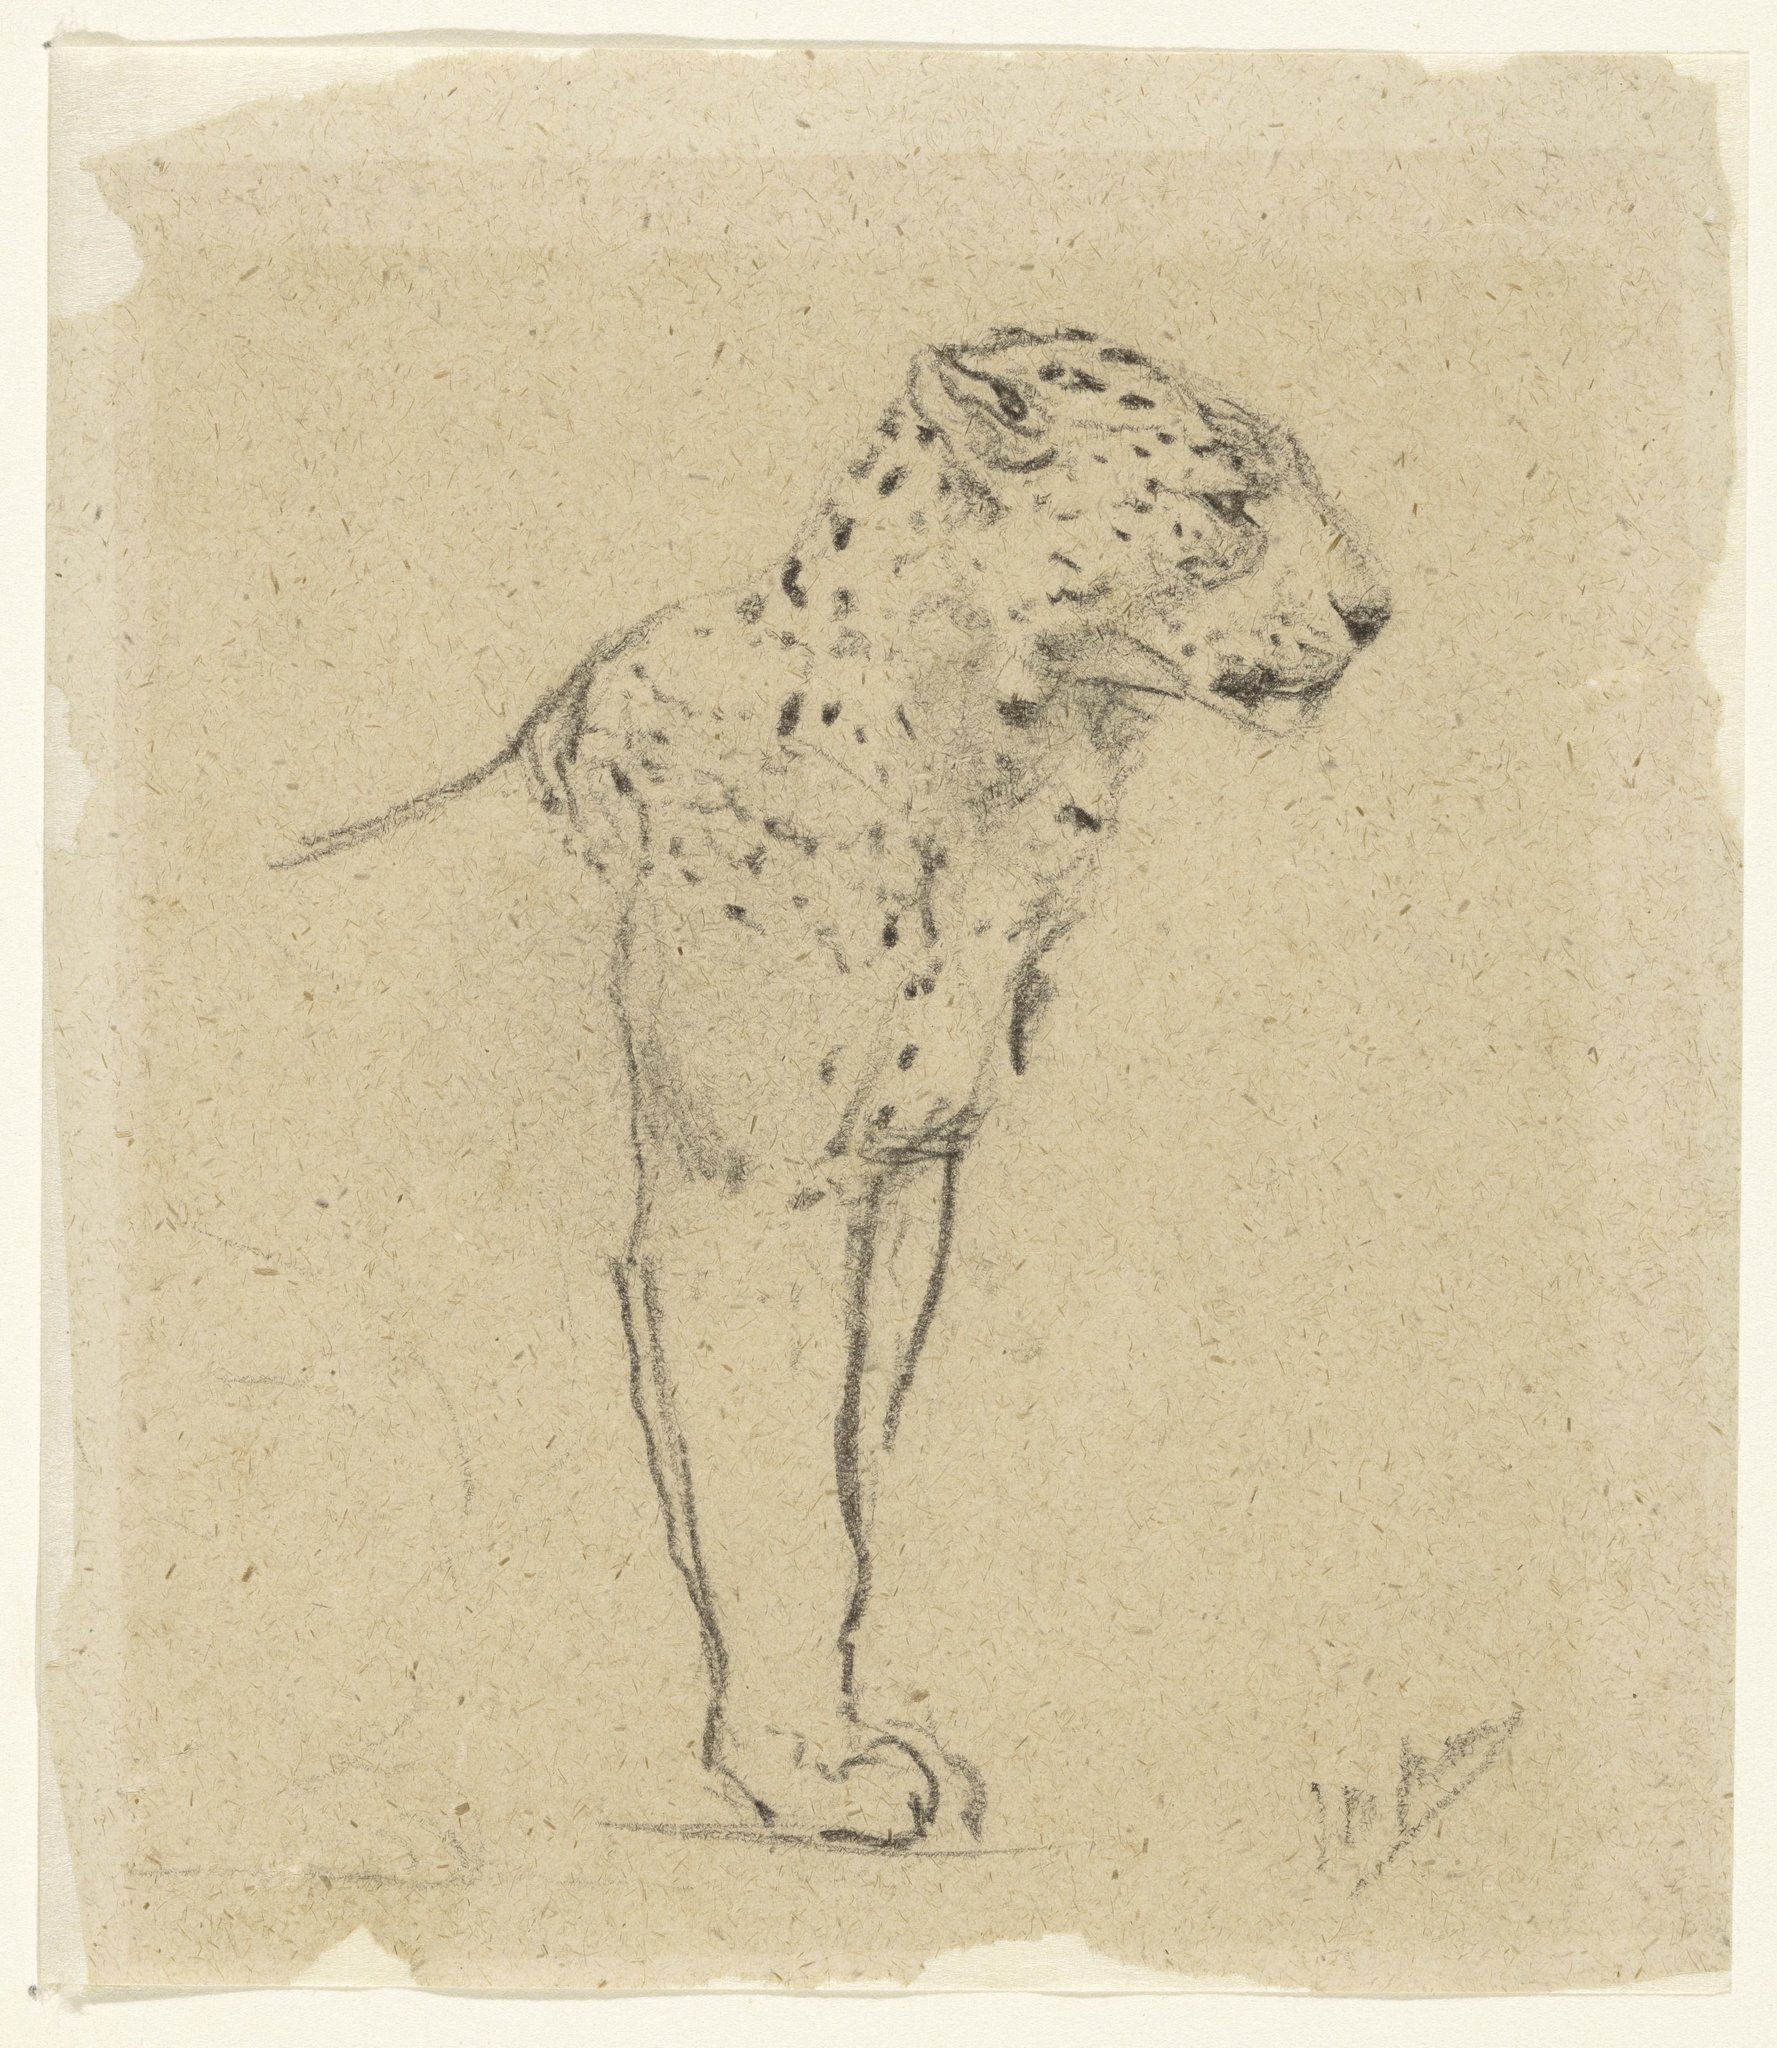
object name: drawing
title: Studie van een staande luipaard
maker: john macallan swan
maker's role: draughtsman, painter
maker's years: 1847-1910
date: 1857-1910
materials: chalk, paper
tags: beasts of prey, predatory animals: leopard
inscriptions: signature: ‘J M Swan’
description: Studie van een staande luipaard, een fragment van zijn kop, borst en voorpoten.